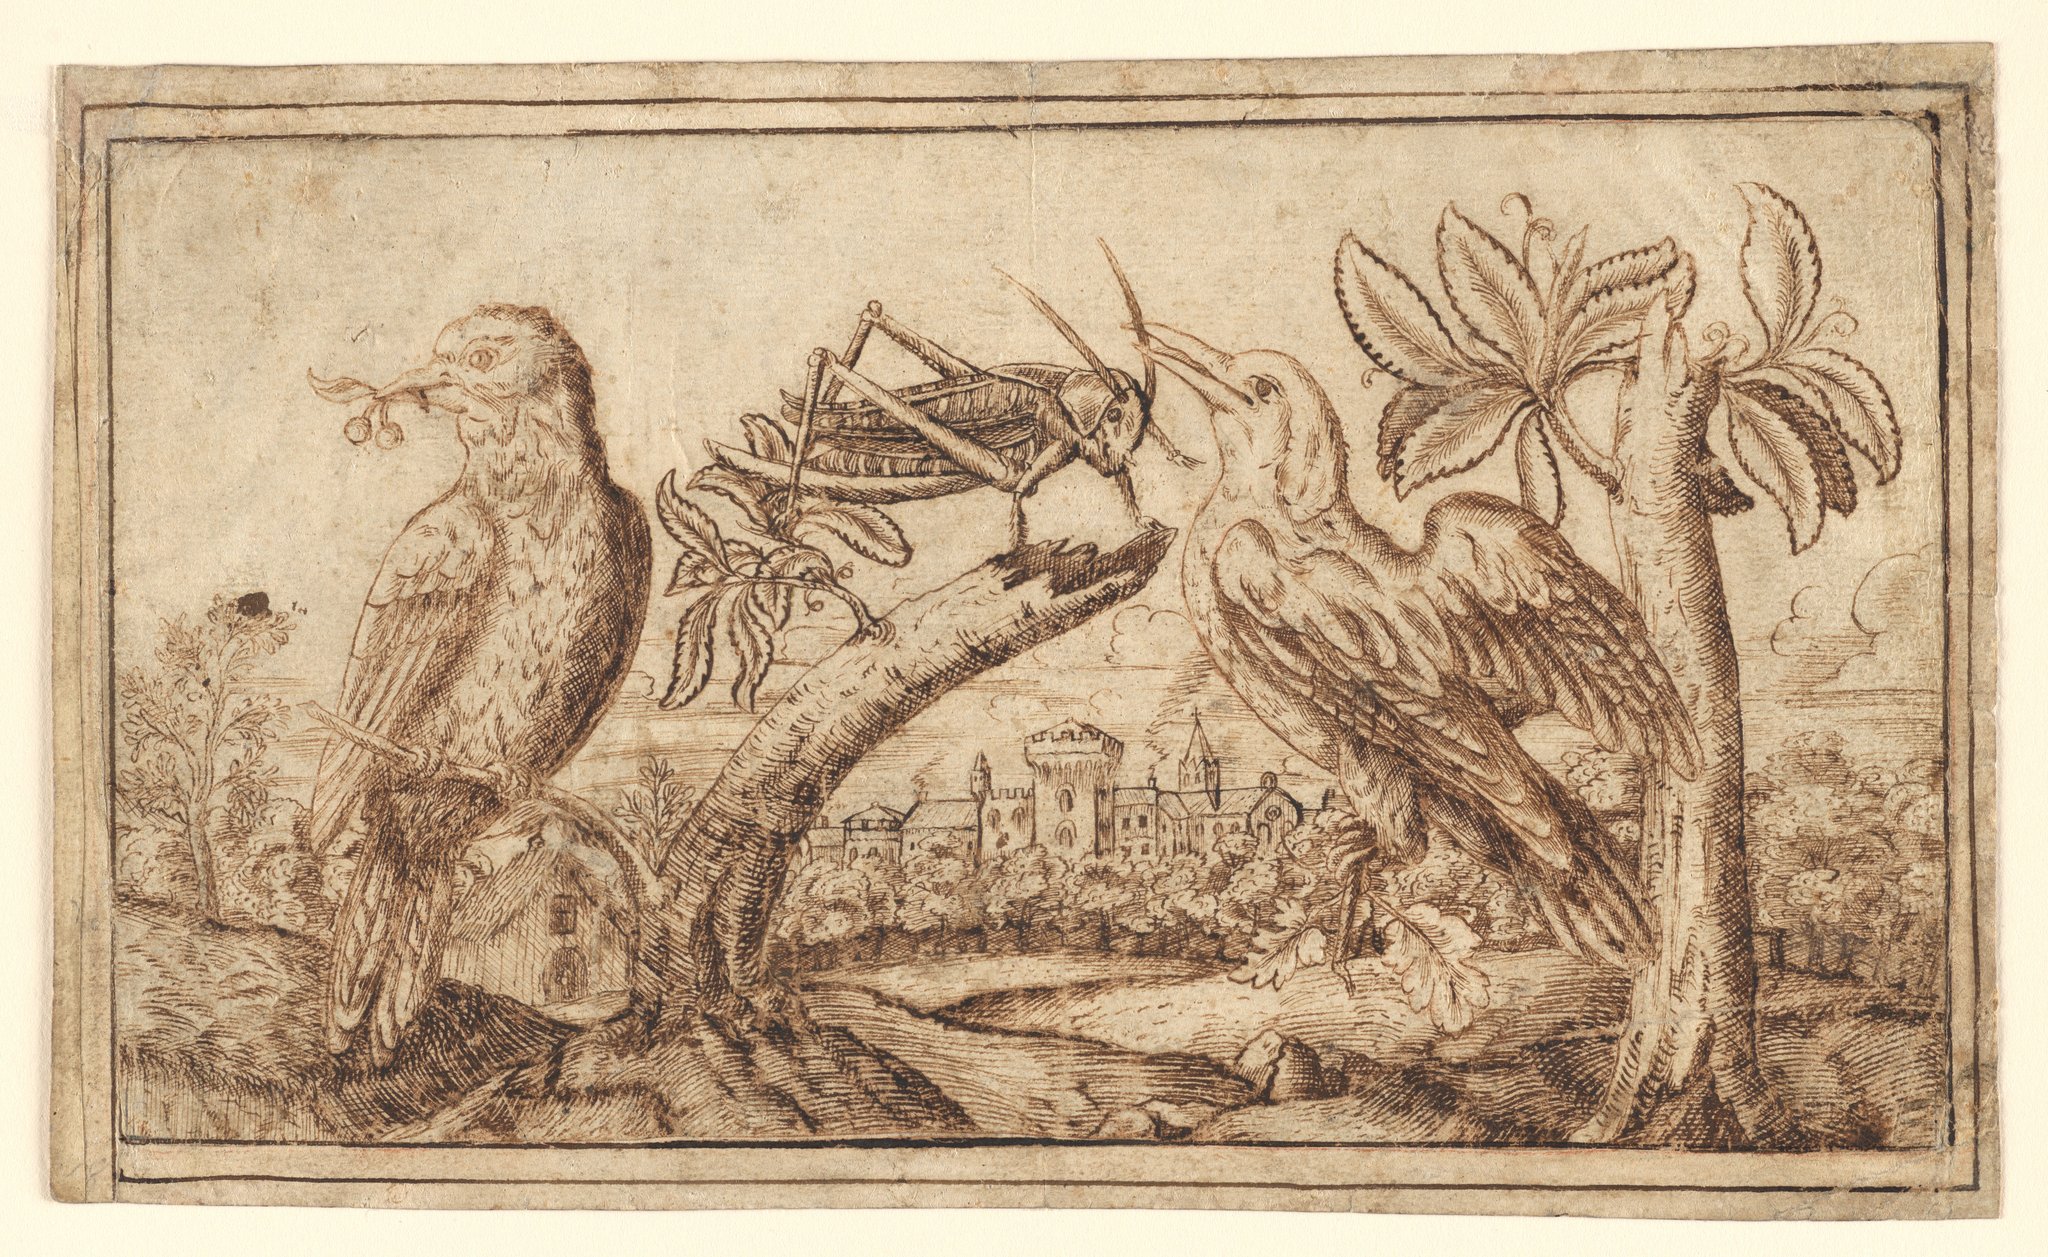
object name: drawing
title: Two Birds and a Cricket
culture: flemish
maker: flanders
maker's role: artist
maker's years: 1600-1699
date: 1667-1700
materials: ink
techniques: pen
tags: birds,insects